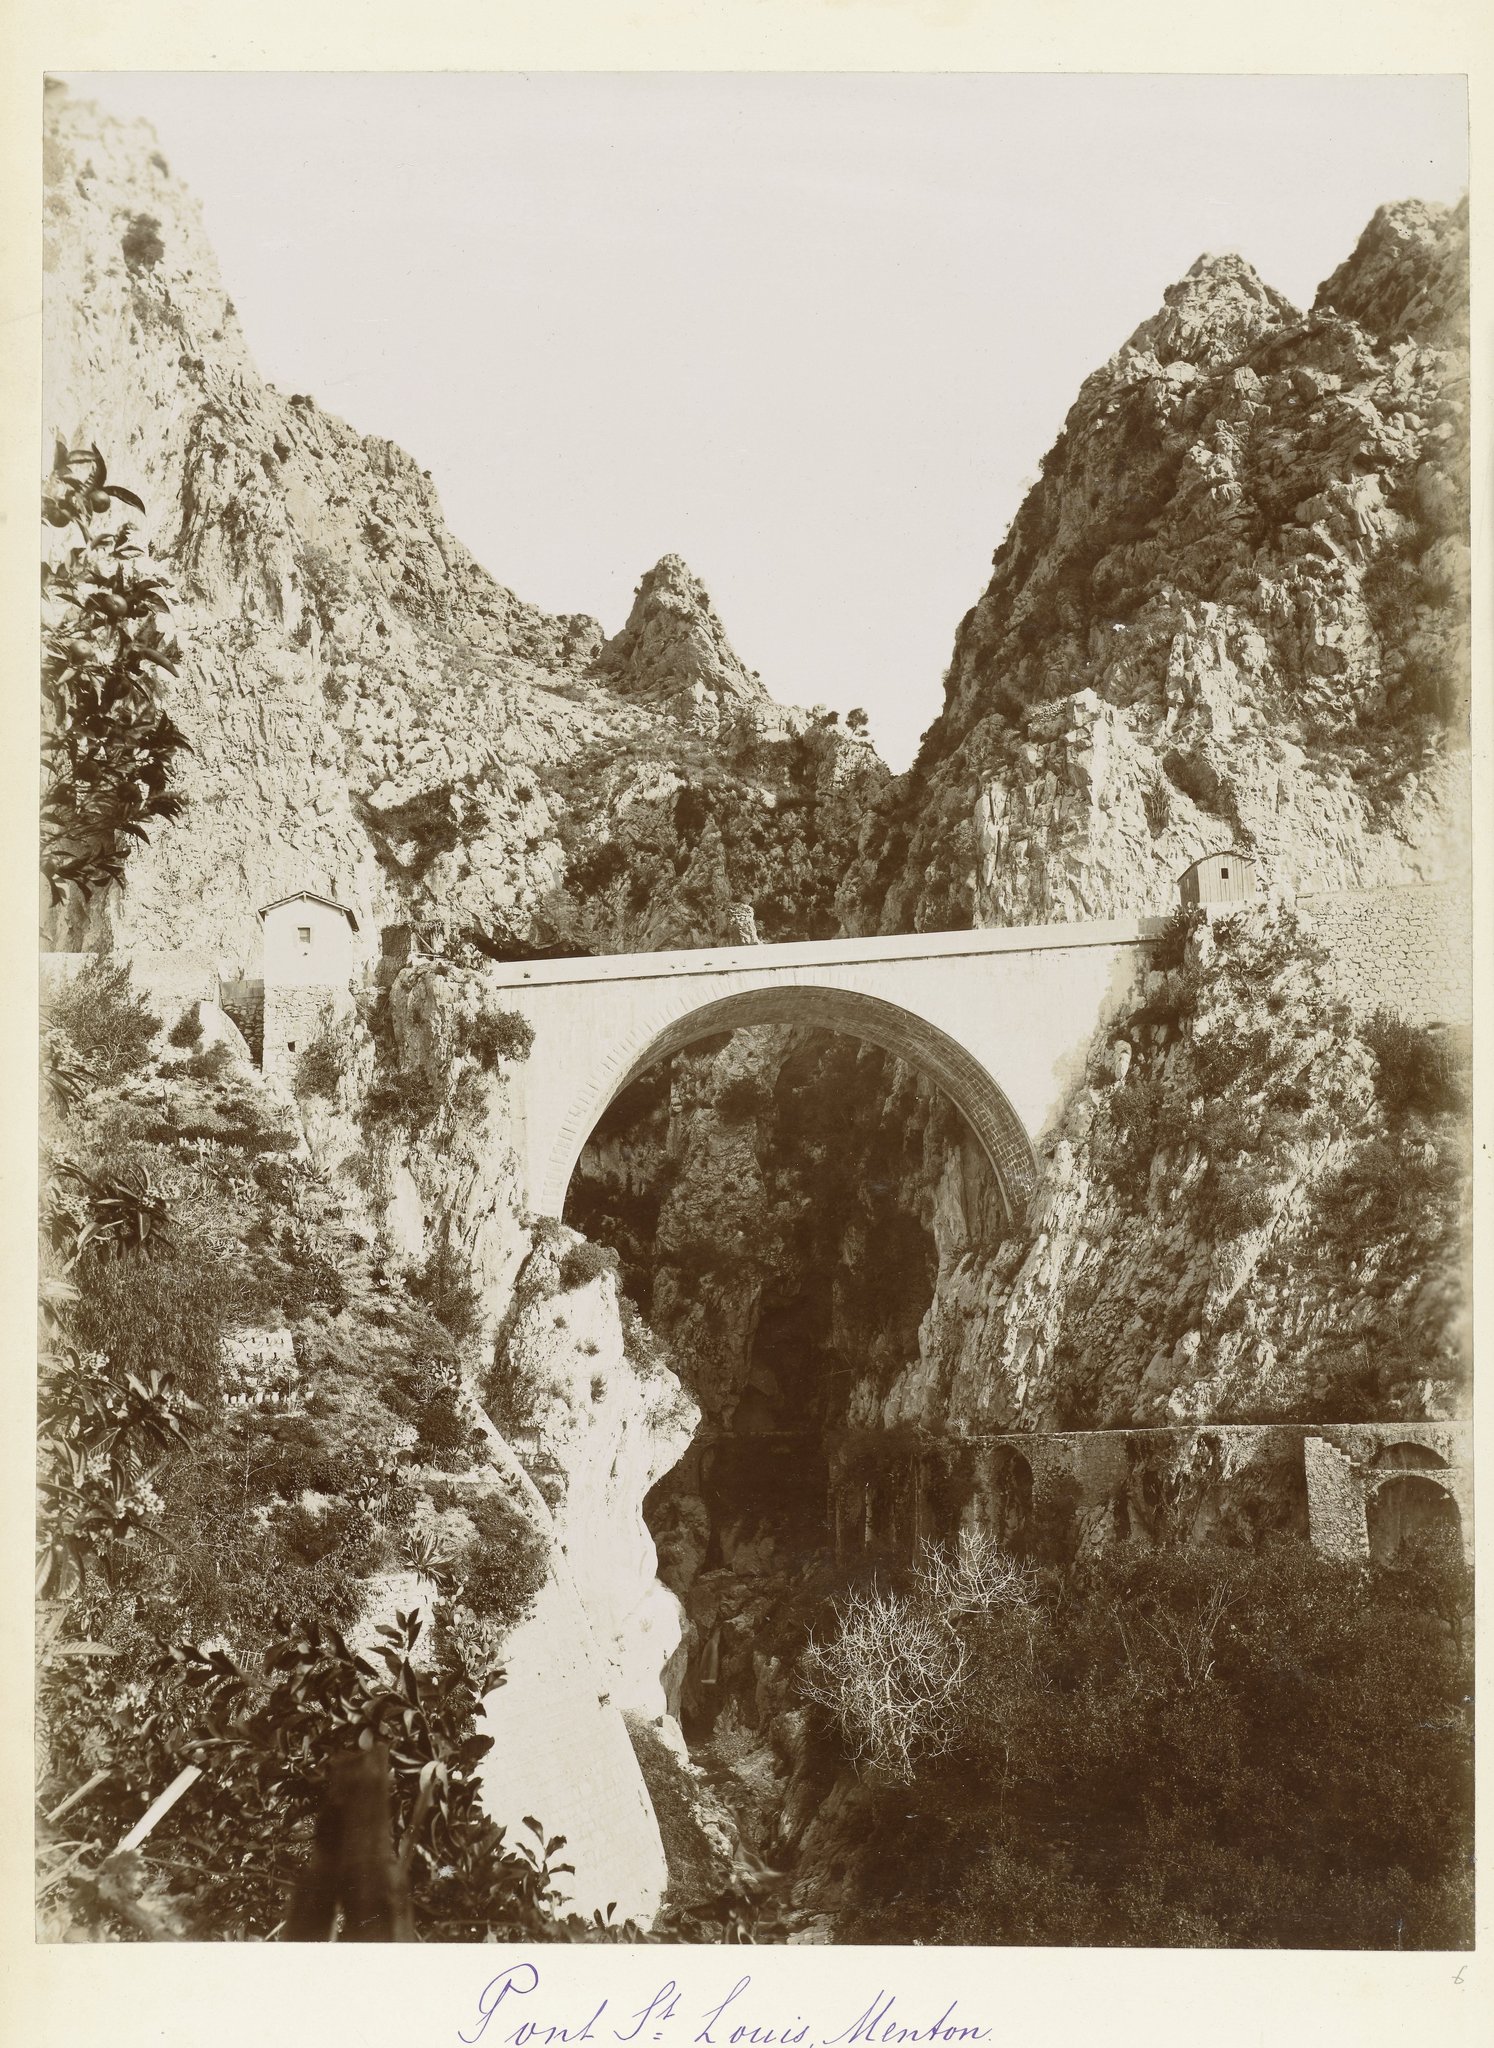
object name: photograph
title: Pont St Louis, Menton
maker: henry pauw van wieldrecht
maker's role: fotograaf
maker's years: 1863-1912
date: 1886-1896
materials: cardboard, photographic support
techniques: albumen print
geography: france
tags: italy, france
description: De brug Saint Louis over de vallei bij Menton. De brug vormt de grens tussen Frankrijk en Italië.